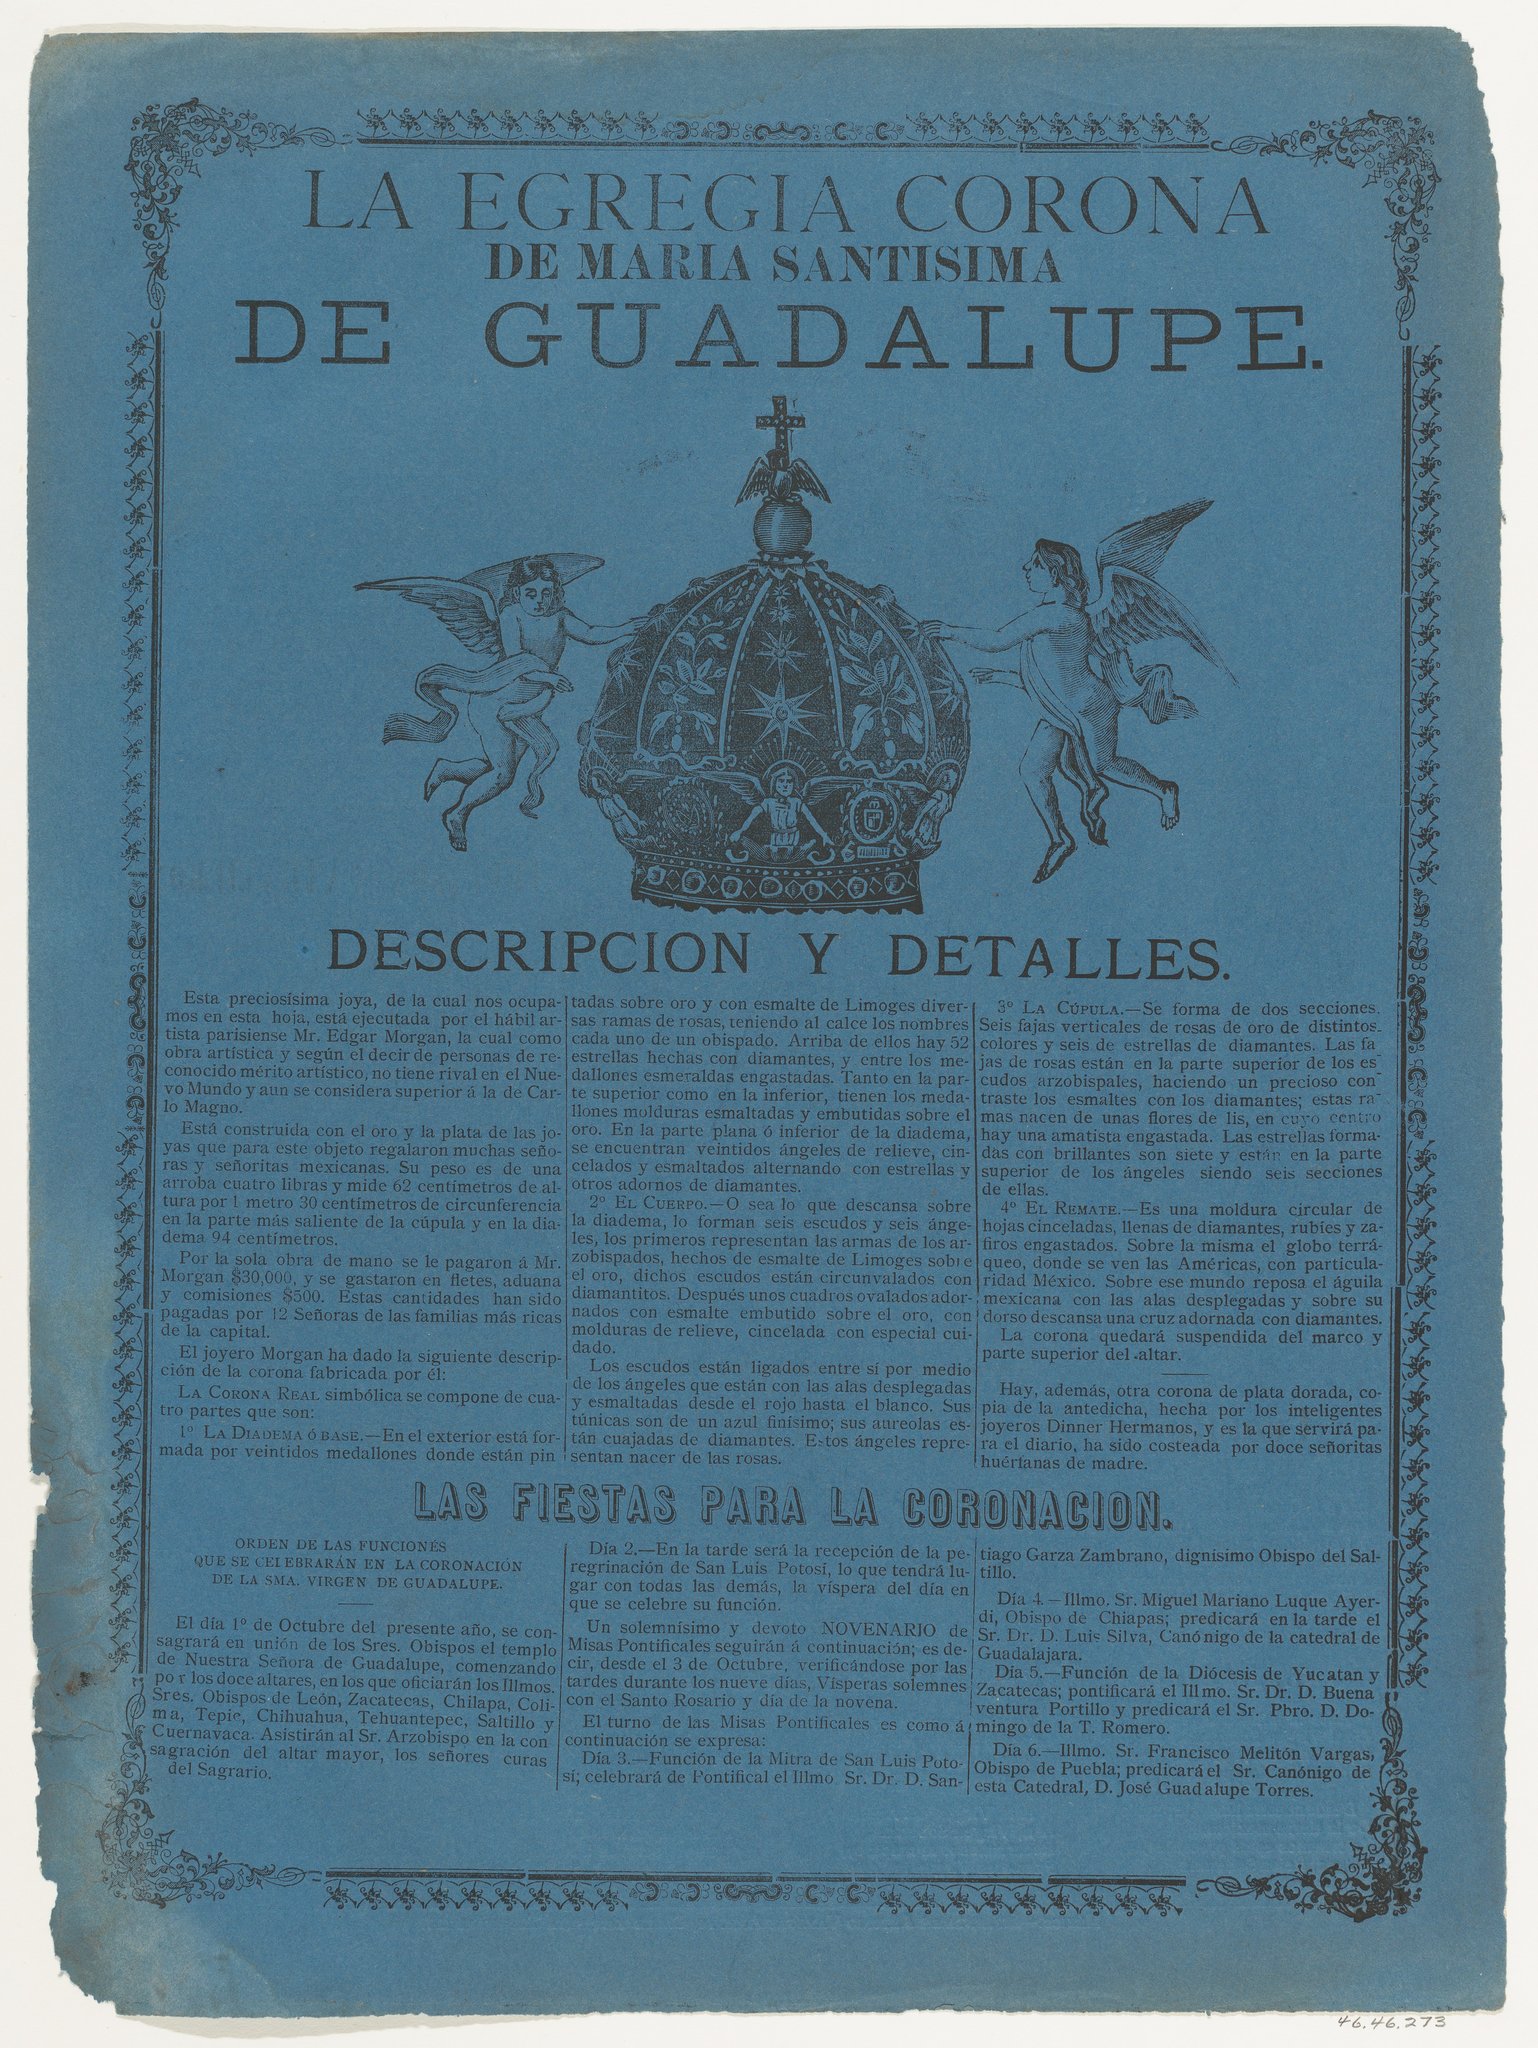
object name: print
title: Broadsheet relating to the crown of the Virgin of Guadalupe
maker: josé guadalupe posada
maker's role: artist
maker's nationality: mexican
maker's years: 1852-1913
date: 1890-1910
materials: metal, paper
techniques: engraving, letterpress